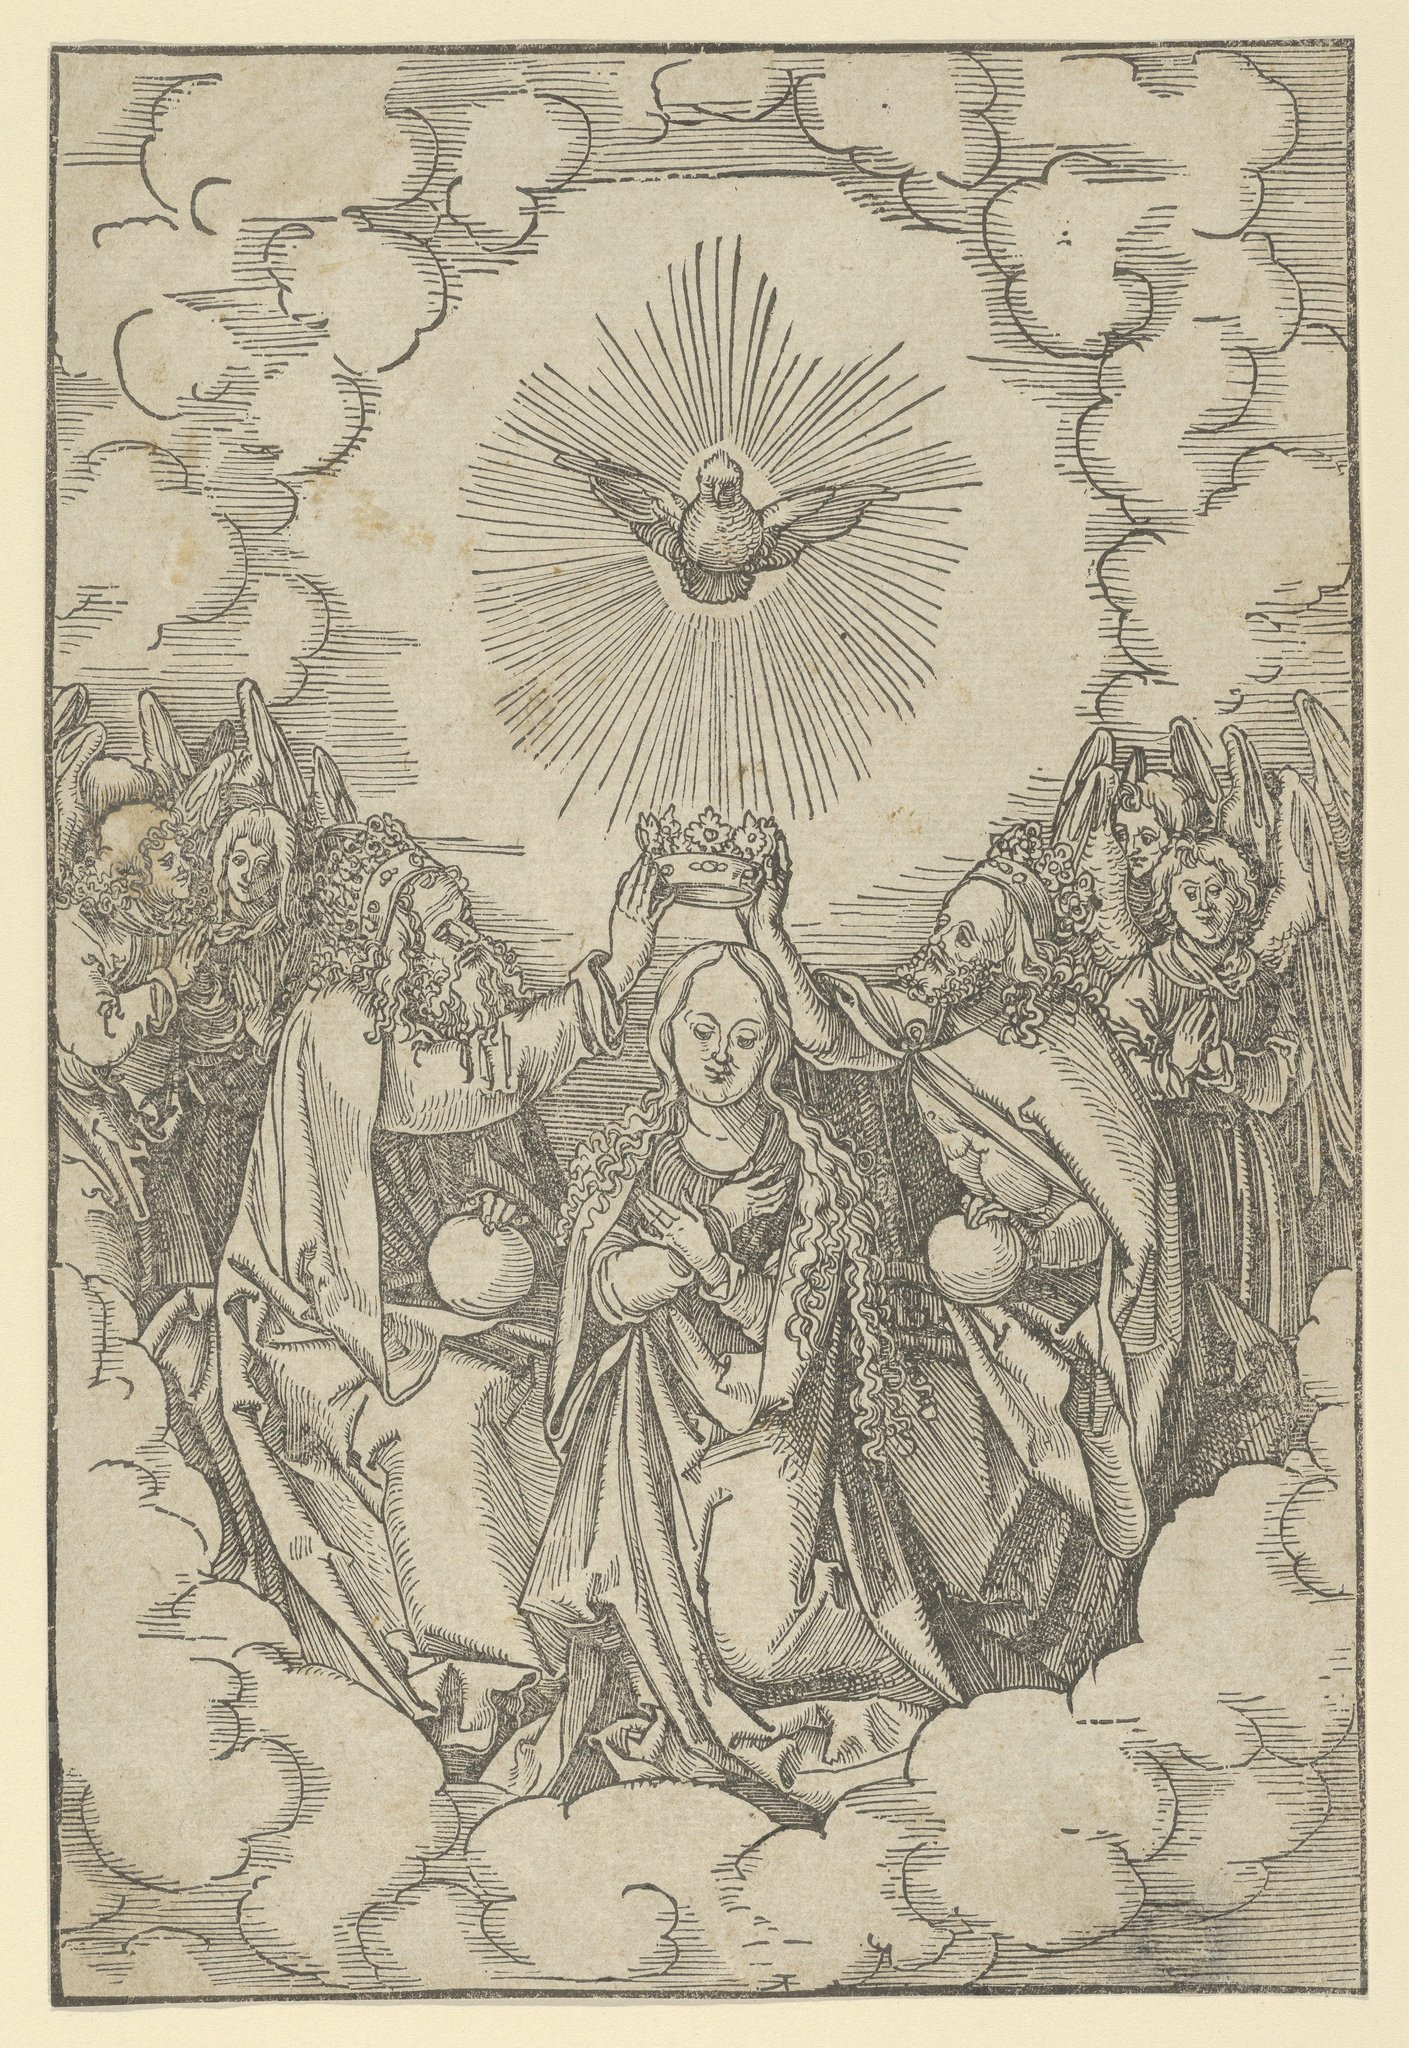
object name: print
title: The Coronation of Mary, from Speculum passionis domini nostri Ihesu Christi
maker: hans schäufelein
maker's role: artist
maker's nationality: german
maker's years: 1480-1540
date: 1507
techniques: woodcut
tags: birds,virgin mary